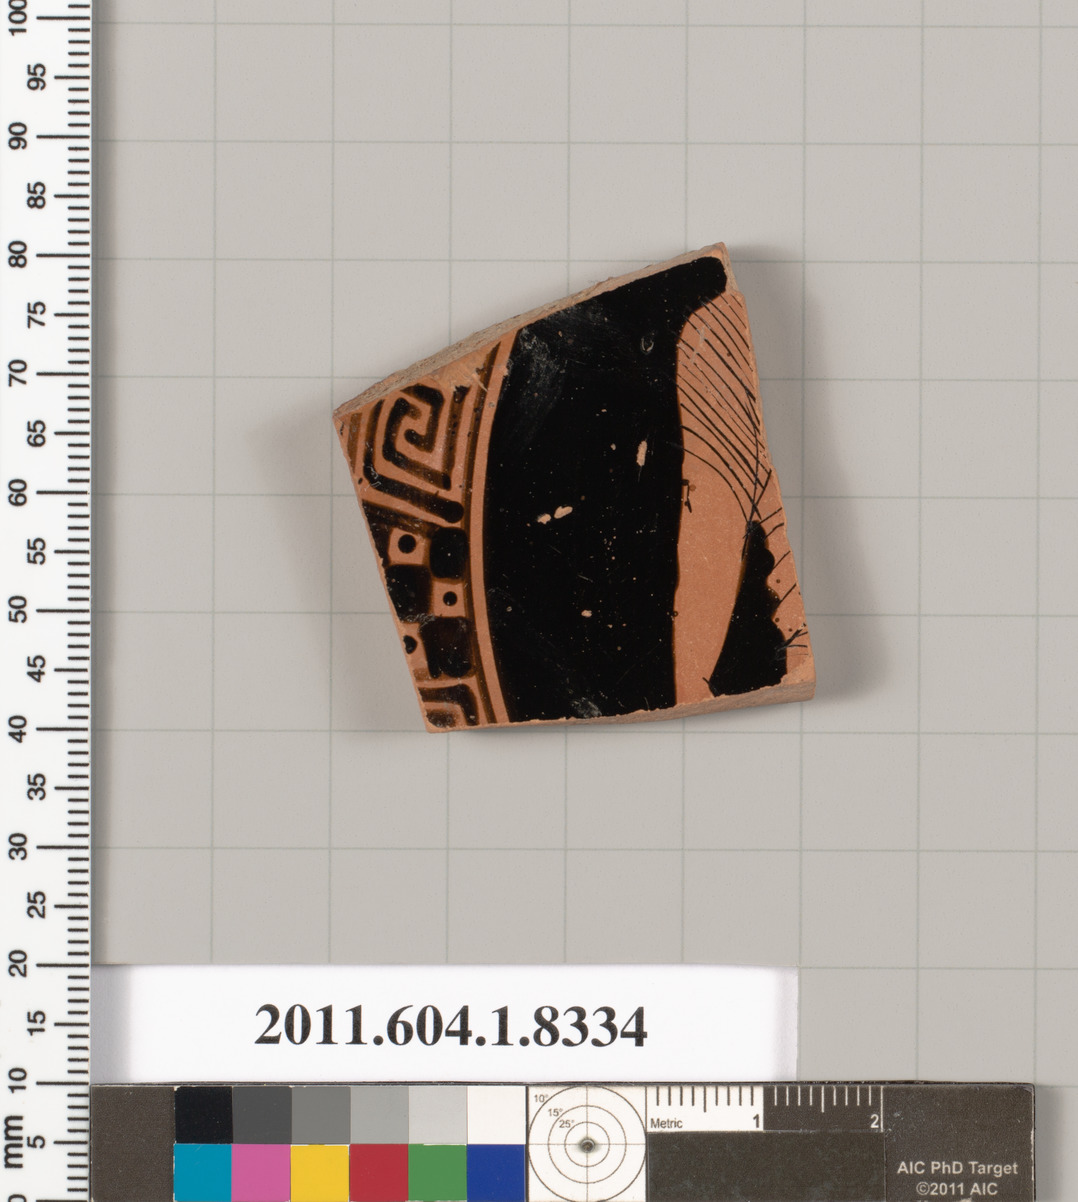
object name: kylix fragment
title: Terracotta fragment of a kylix (drinking cup)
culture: greek, attic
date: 434-401 BCE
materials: terracotta